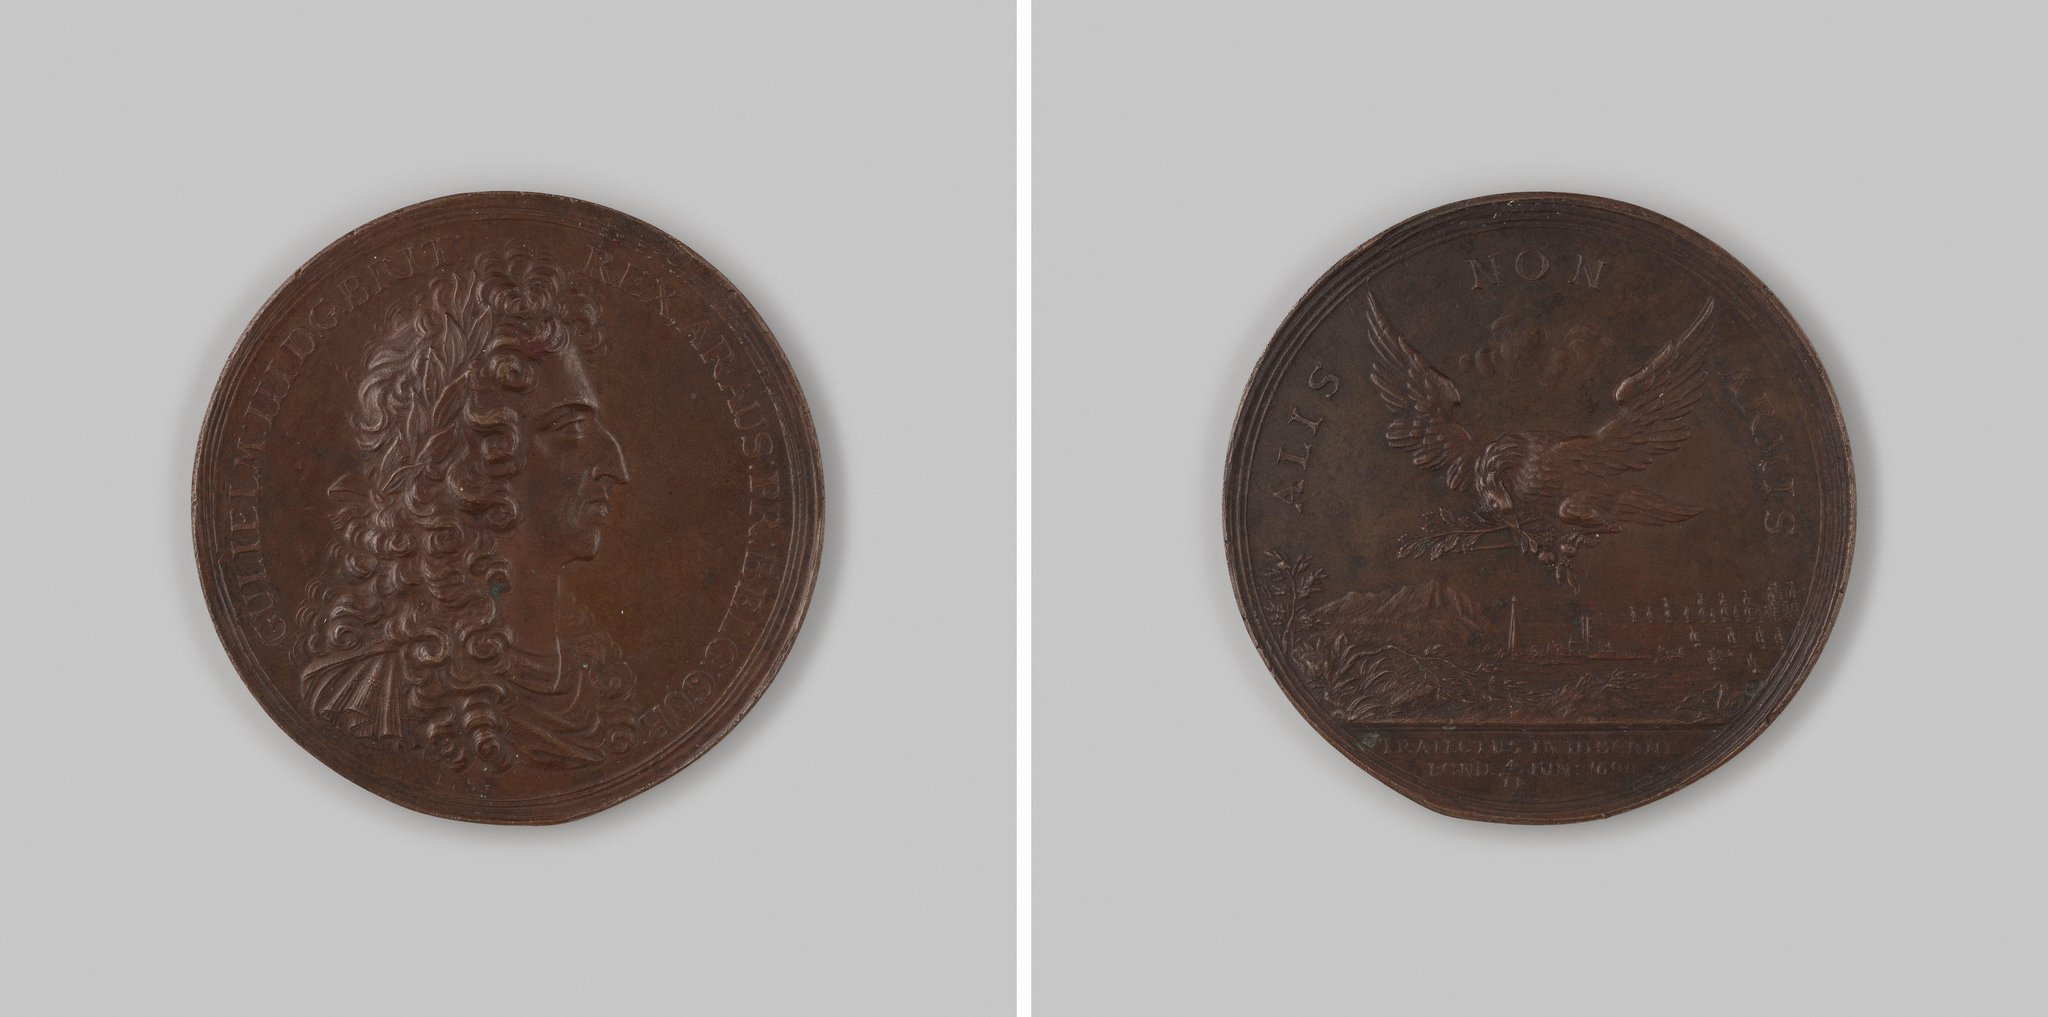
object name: history medal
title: Overtocht van Willem III naar Ierland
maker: jan smeltzing (i)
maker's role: modelleur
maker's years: 1656-1693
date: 1690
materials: bronze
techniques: striking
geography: leiden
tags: the hague, william iii (prince of orange and king of england, scotland, and ireland)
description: Bronzen penning. Voorzijde: borststuk man met lauwerkrans binnen omschrift. Keerzijde: arend vliegend boven land met scepter, lauwer- en oranjetak in zijn bek, op achtergrond naderende vloot binnen omschrift; afsnede: opschrift